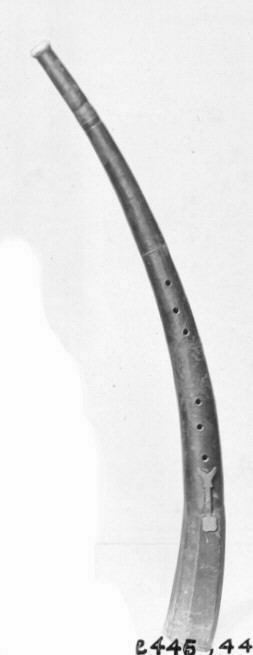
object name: tenor cornetto in d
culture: french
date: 1601-1700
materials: leather, metal, wood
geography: france